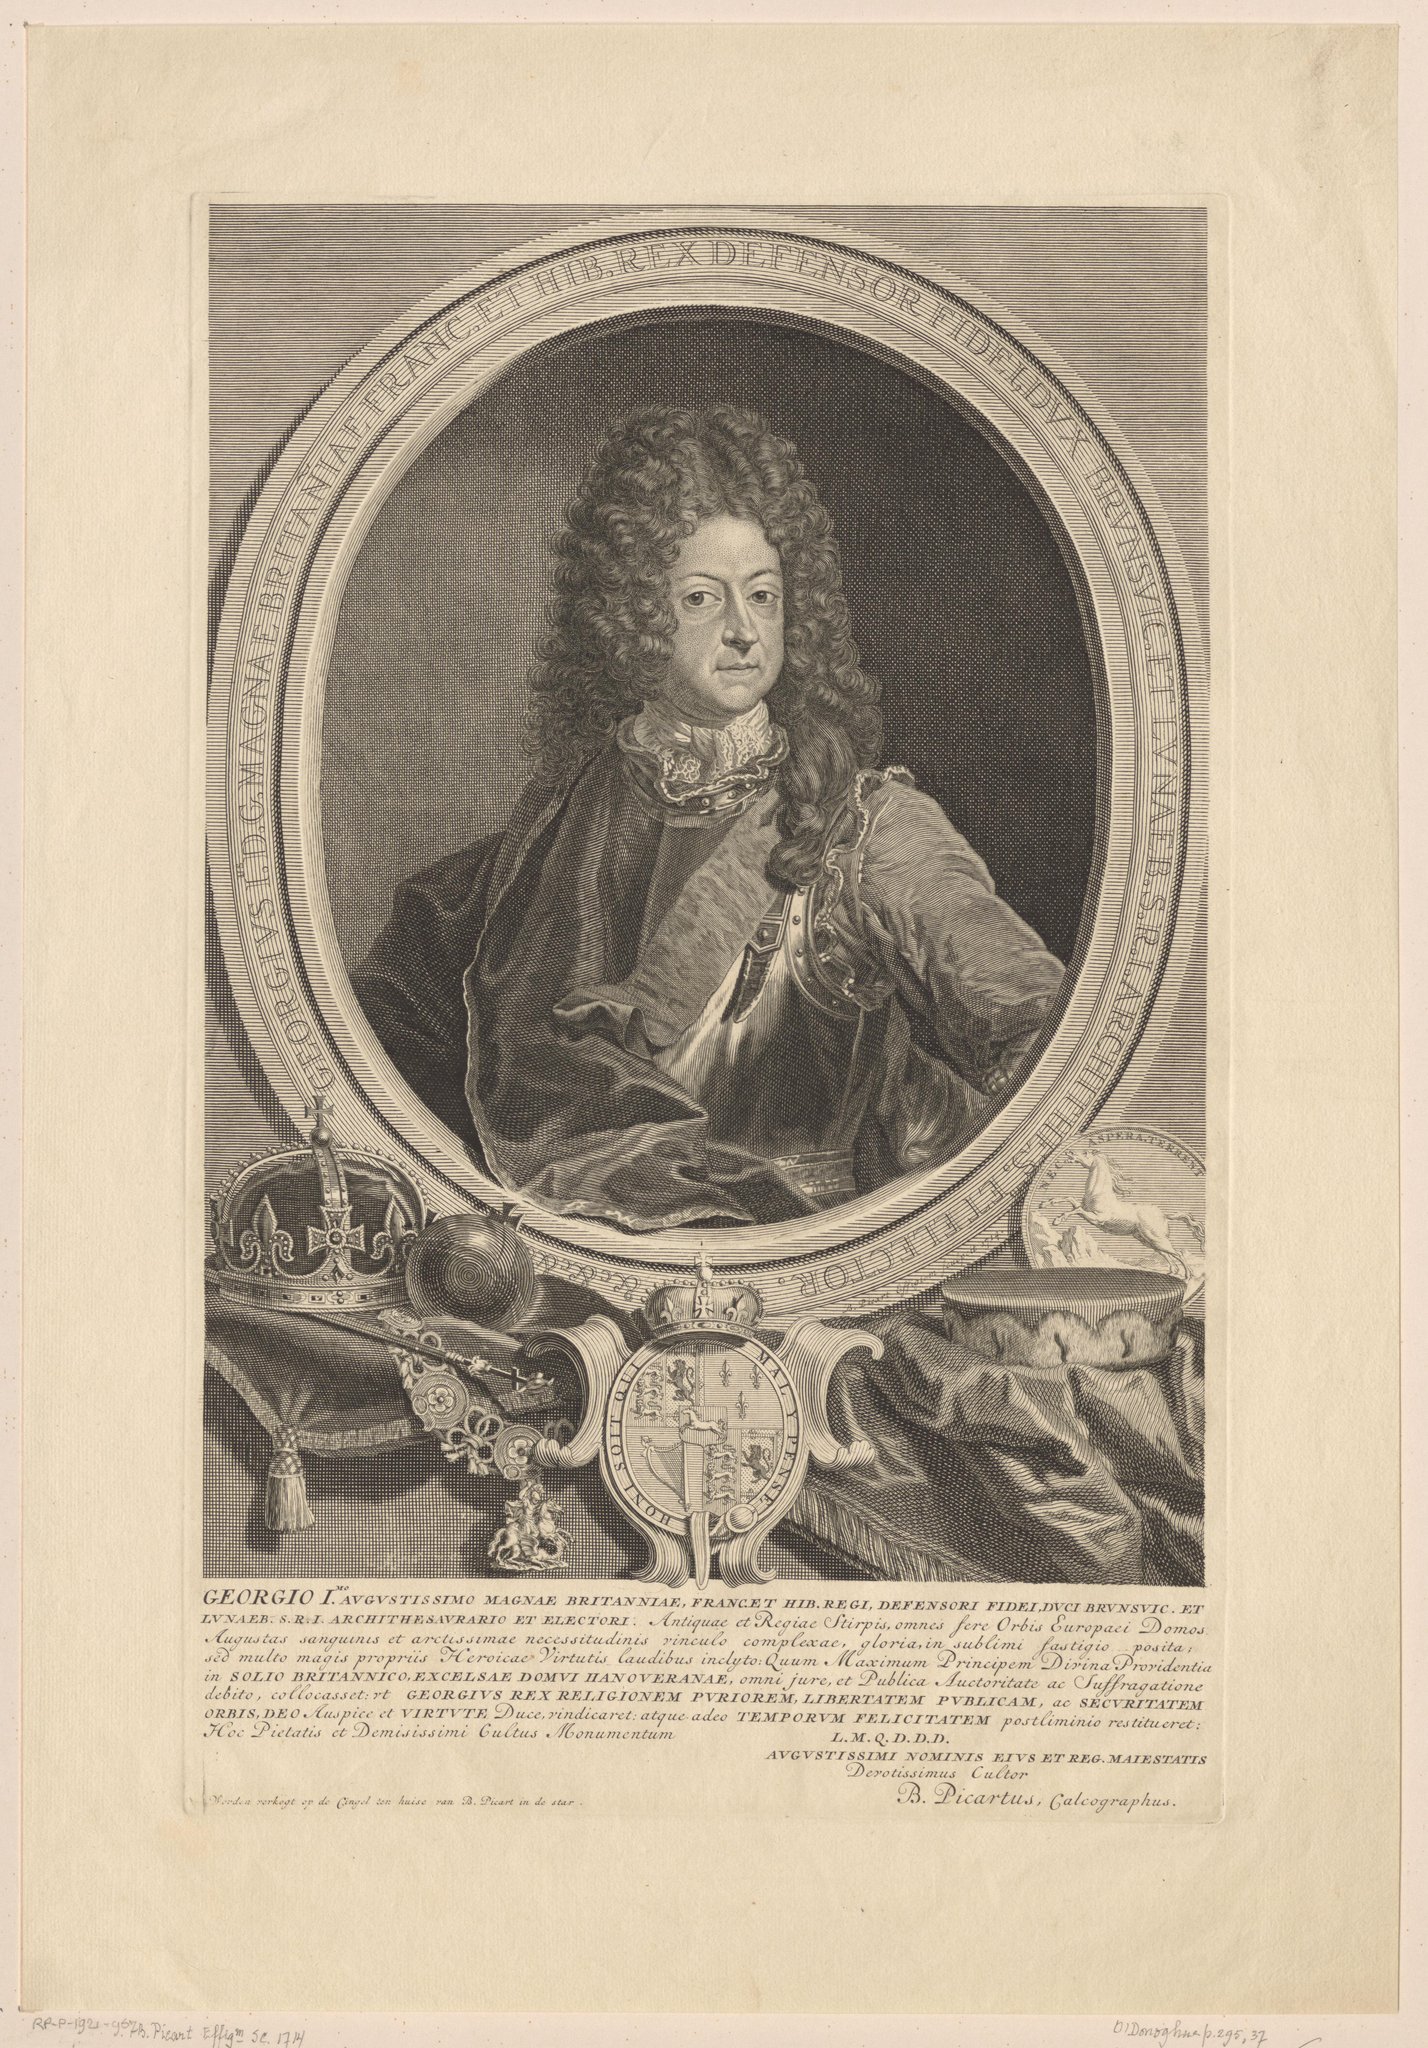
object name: print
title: Portret van George I, koning van Groot-Brittannië en Ierland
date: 1714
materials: paper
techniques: engraving, etching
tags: george i (koning van groot-brittannië en ierland), historical persons, king, armorial bearing, heraldry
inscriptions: collector's mark: Lugt 2233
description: Onder de omlijsting zijn wapenschild met zijn devies in het Latijn. Op een draperie een kroon, een rijksappel, een keten met de Constantijnse Orde van Sint Joris en een medaillon waarop een paard. Onderaan een achtregelig onderschrift in het Latijn.